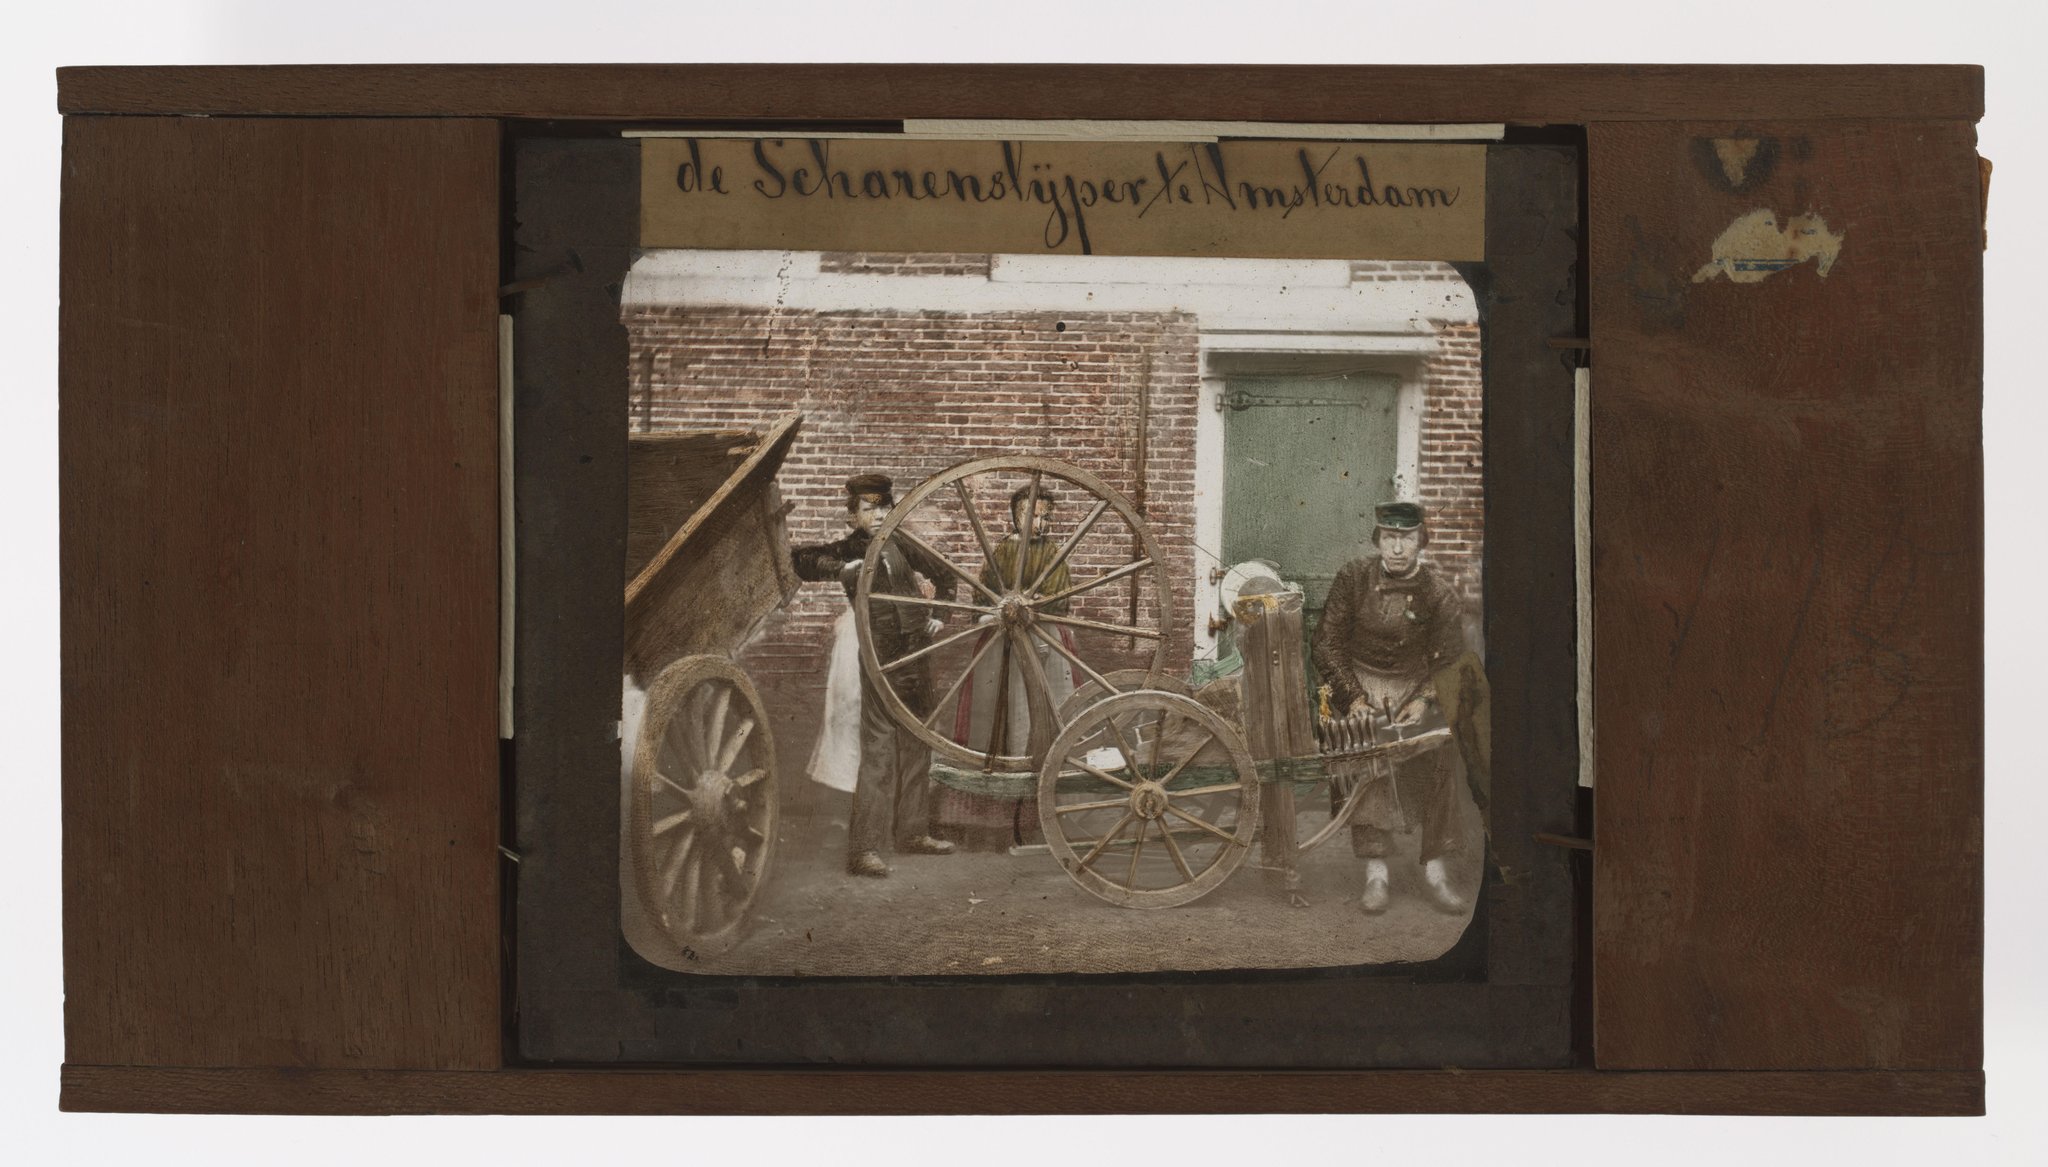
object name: lantern slide photographic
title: Drie mannen bij een scharensliep, Amsterdam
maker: Anonymous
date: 1880-1910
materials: glass, metal, tape, wood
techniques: hand coloring, slide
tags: tools, aids, implements ~ crafts and industries: scissors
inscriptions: number: ‘118’